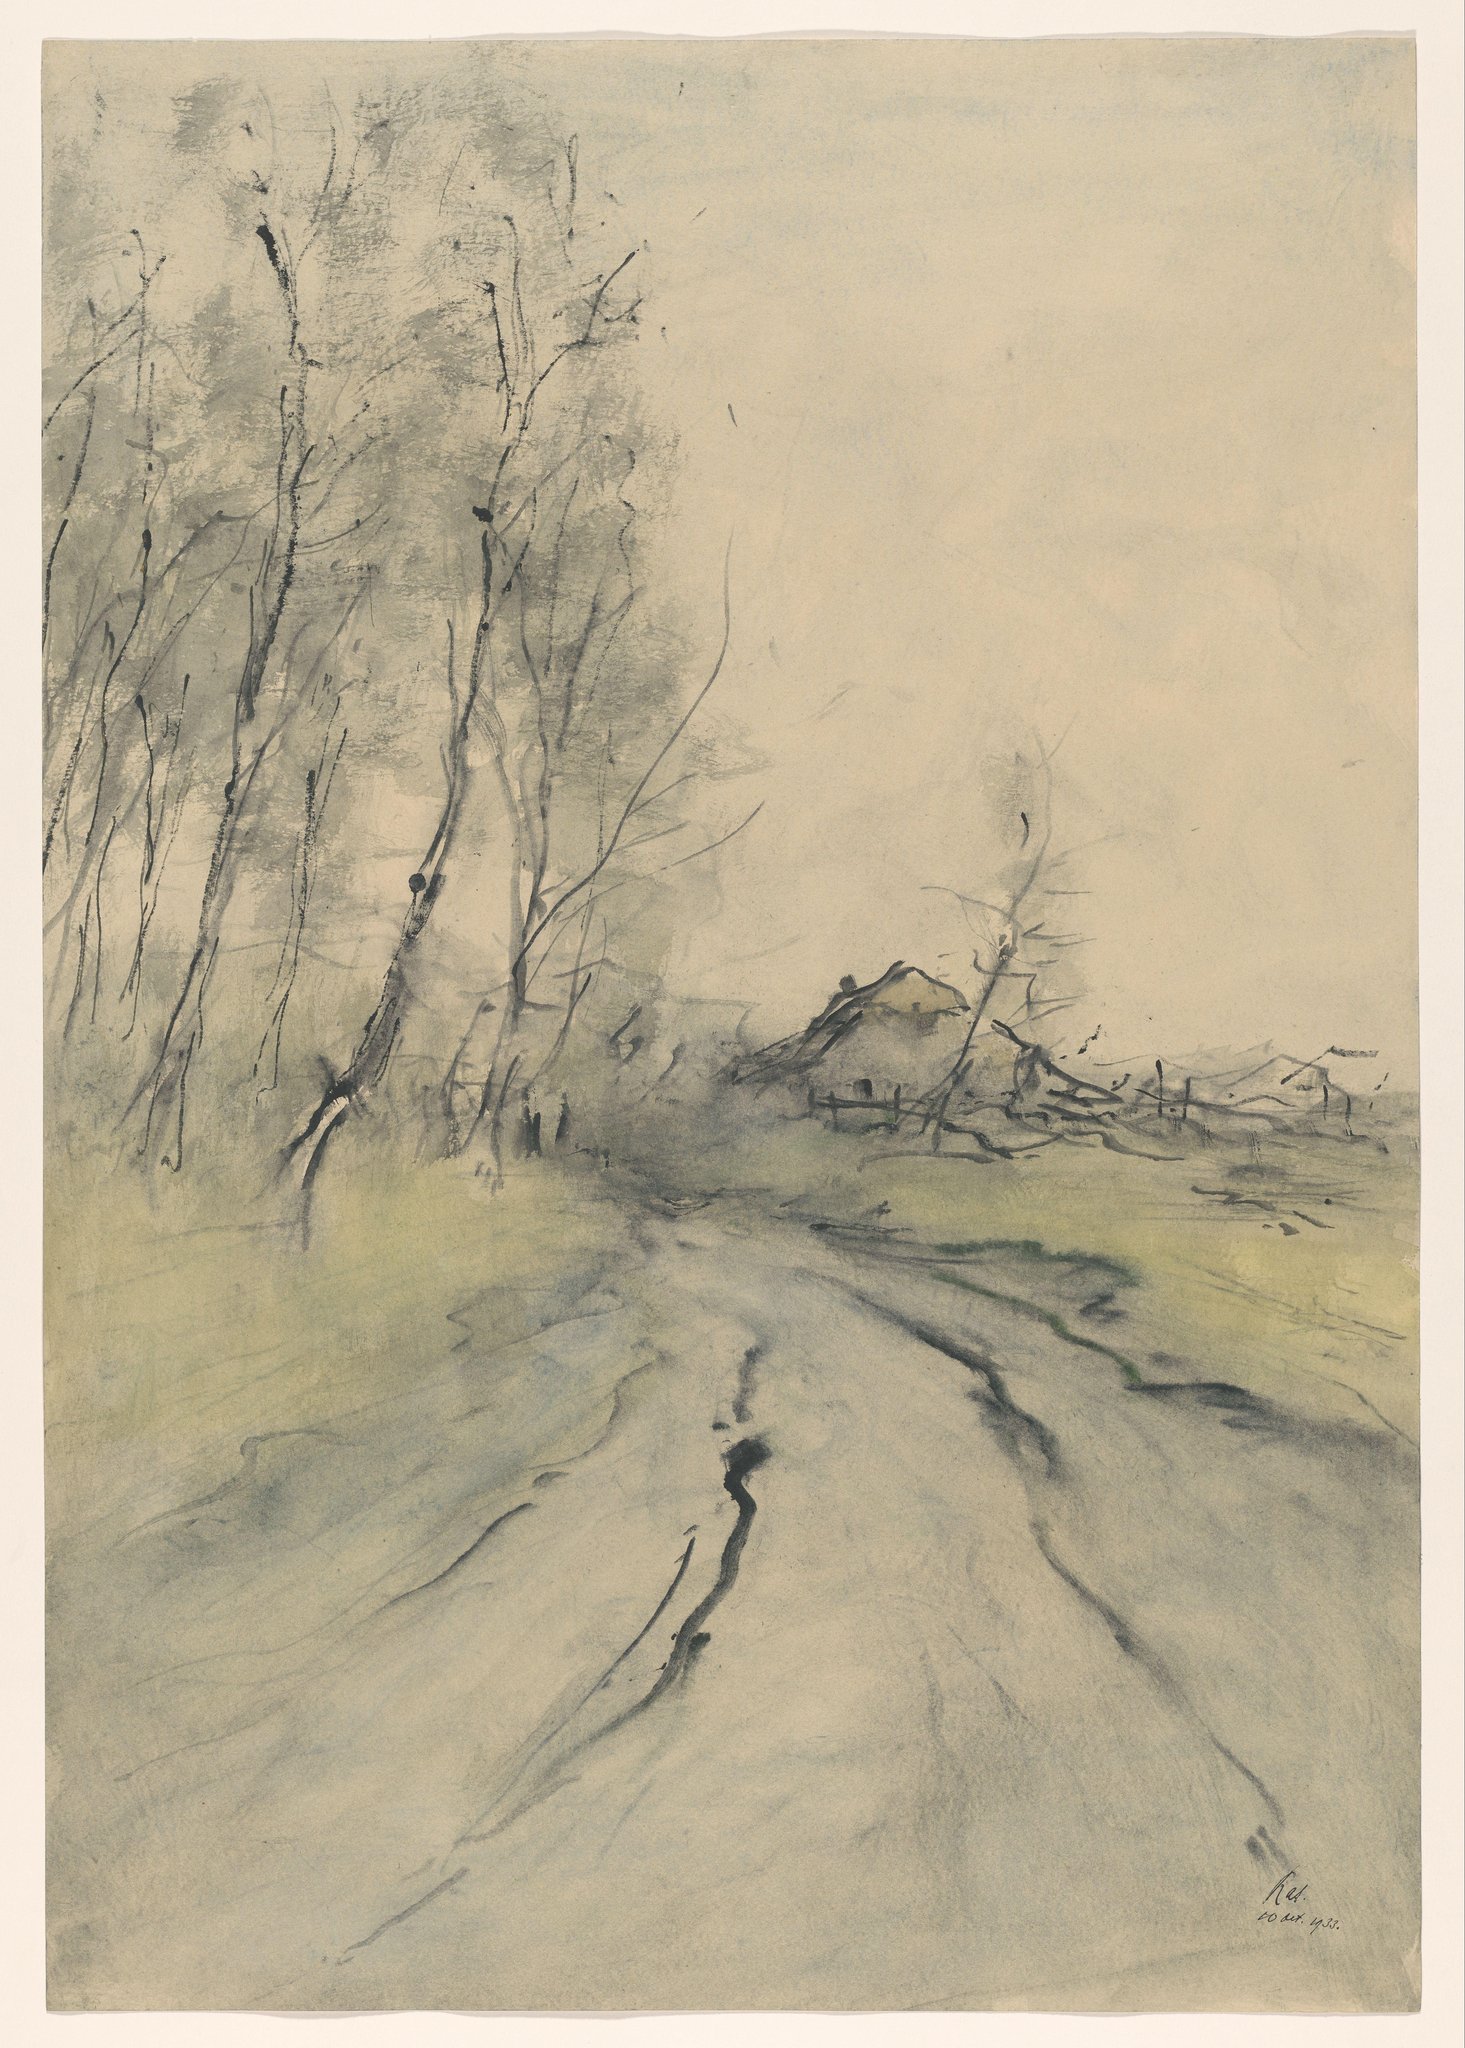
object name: drawing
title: Landweg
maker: pieter h.j.j. ras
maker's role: draughtsman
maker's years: 1857-1941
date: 1933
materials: paper, watercolor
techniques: brush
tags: trees, road, path